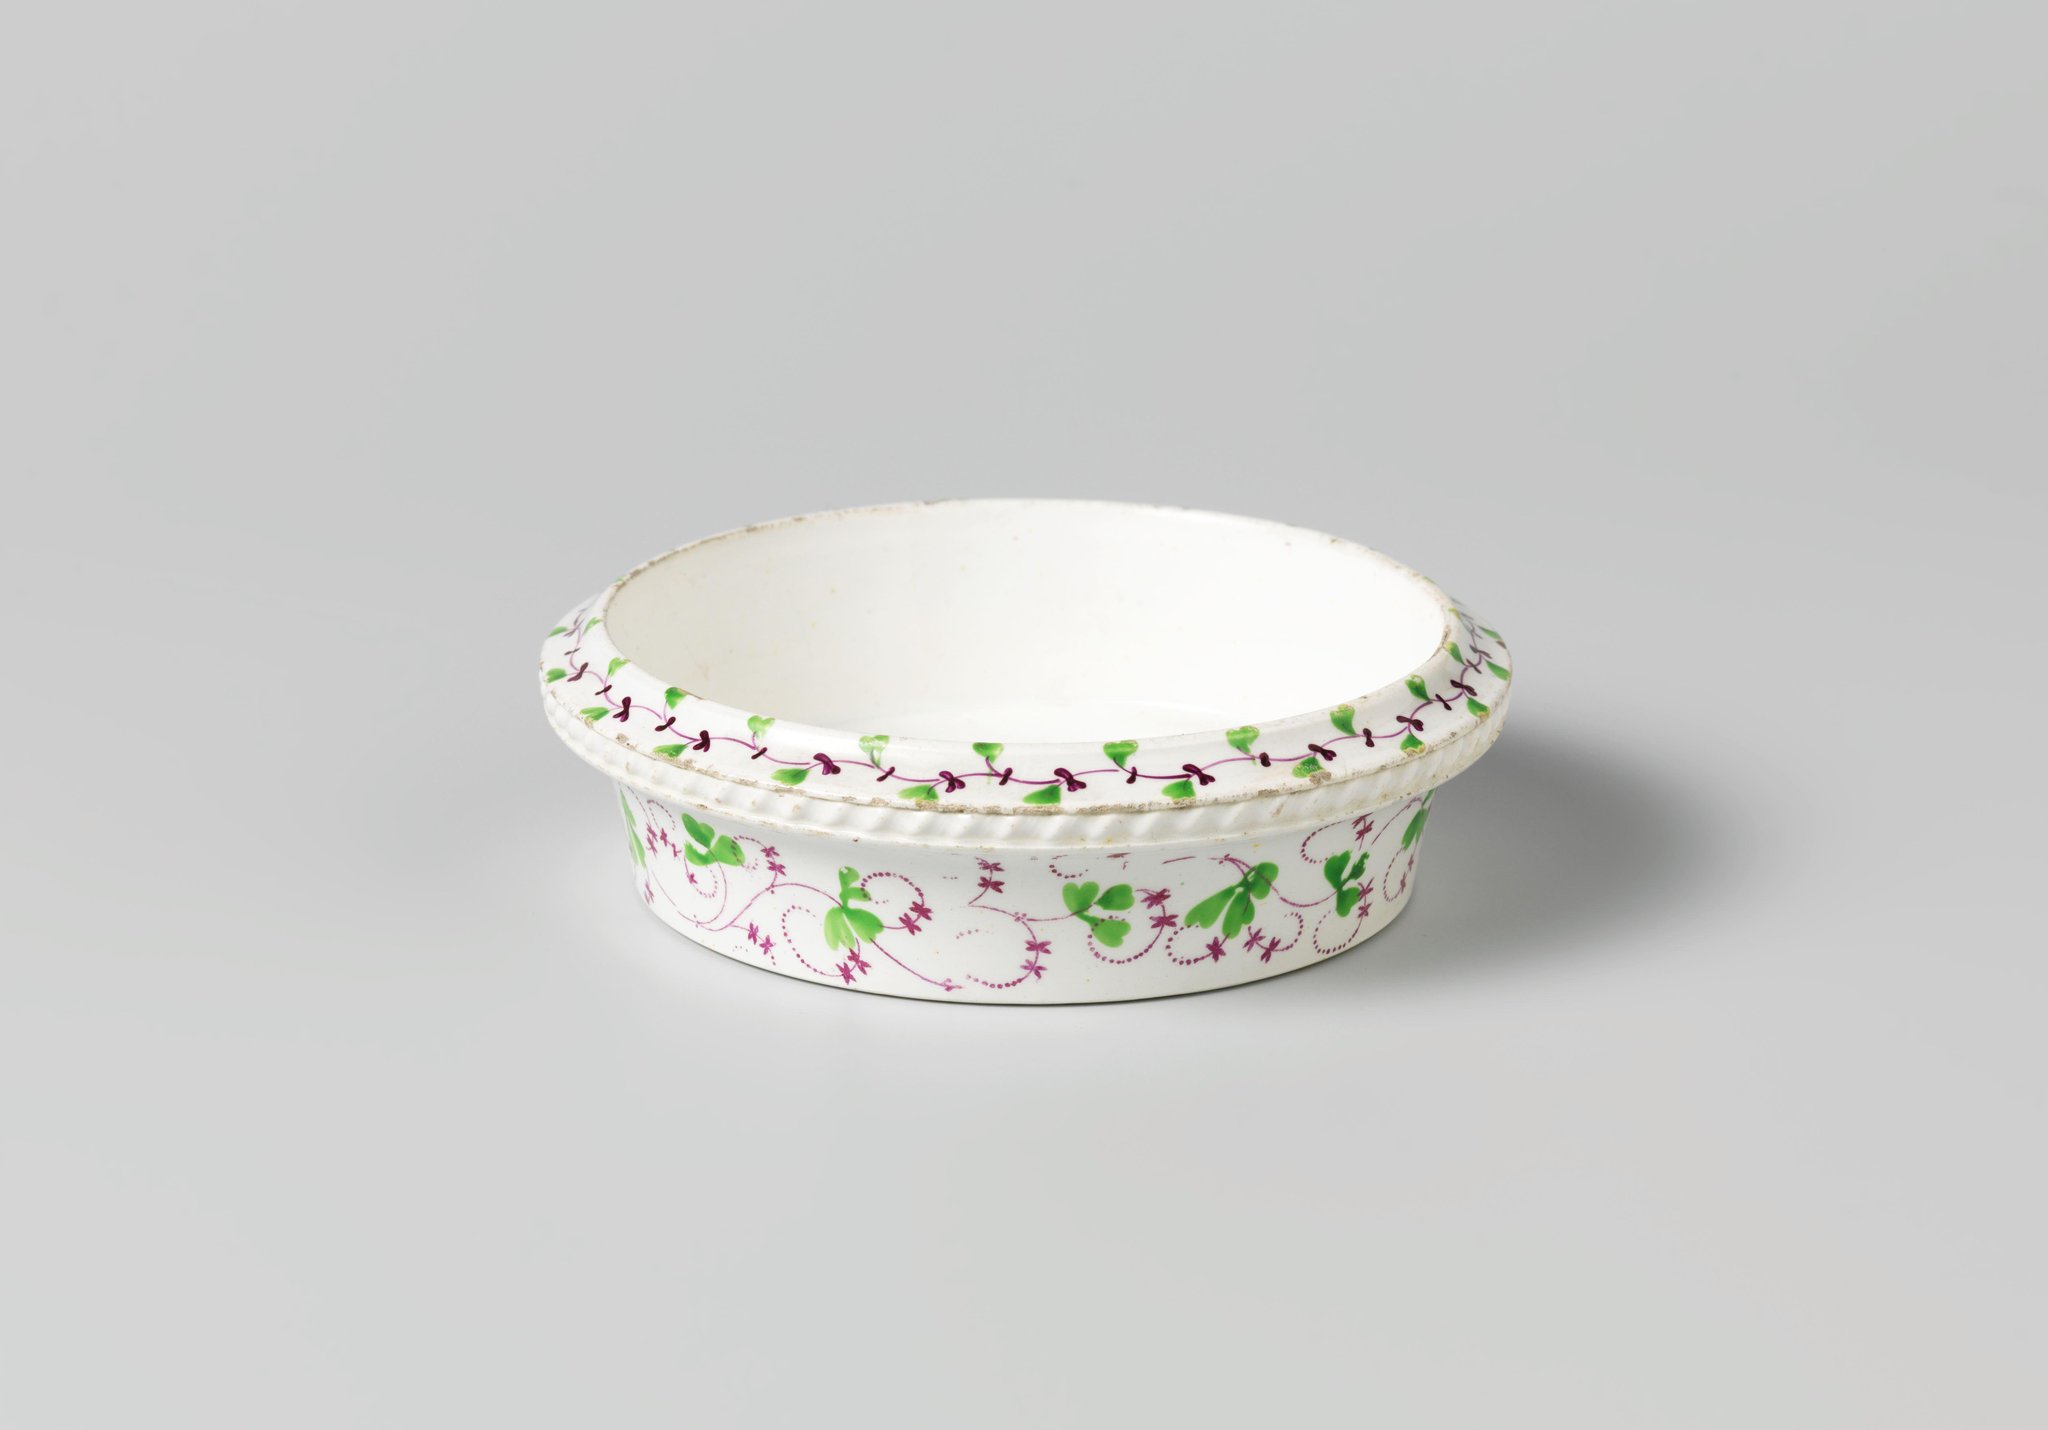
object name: platter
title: Schotel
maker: Anonymous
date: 1770-1810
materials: earthenware, glaze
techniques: painted, polychromy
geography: france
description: Ronde schotel met opstaande rand, van veelkleurig beschilderde faiences fines. De schotel is beschilderd met paarse, dunne takken met groene bladeren. Onder de rand is de wand verdikt en geribd. De schotel hoort bij een bloempot (vgl. invnrs. BK-NM-14097-e en BK-NM-14097-f). Bij de schotel horen drie schotels met invnrs. BK-NM-14097-b, BK-NM-14097-c en BK-NM-14097-d.